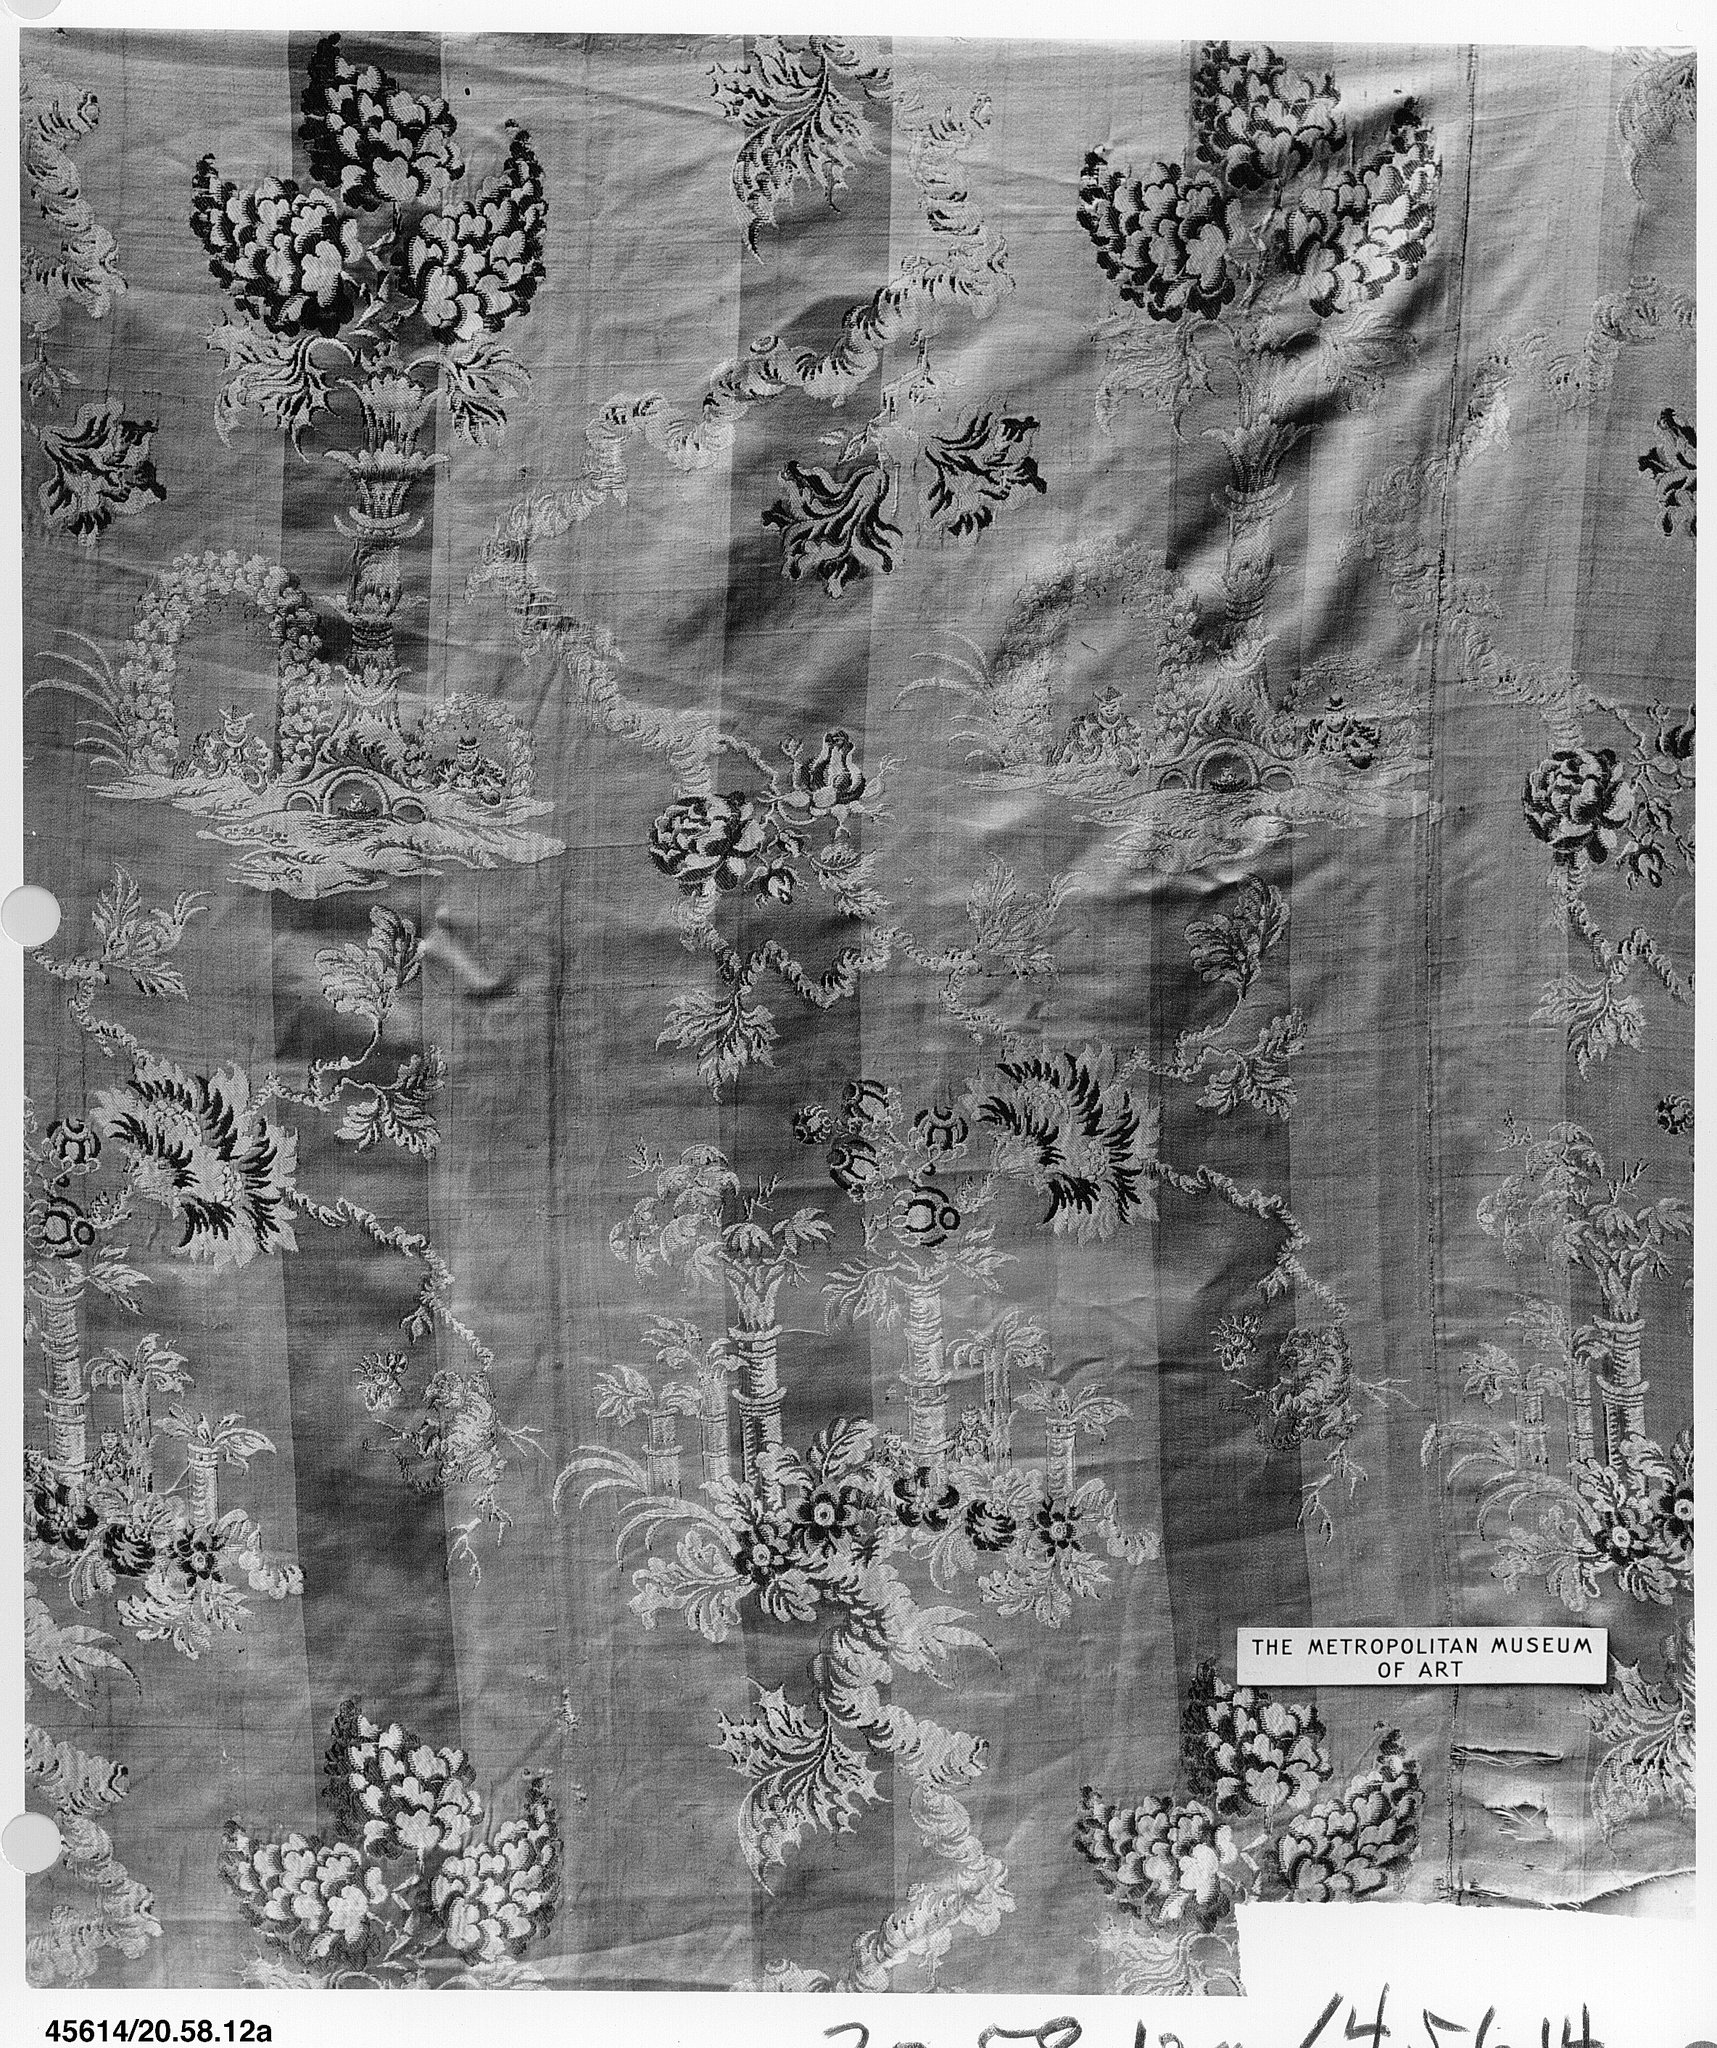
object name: piece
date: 1735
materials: silk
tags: flowers,trees